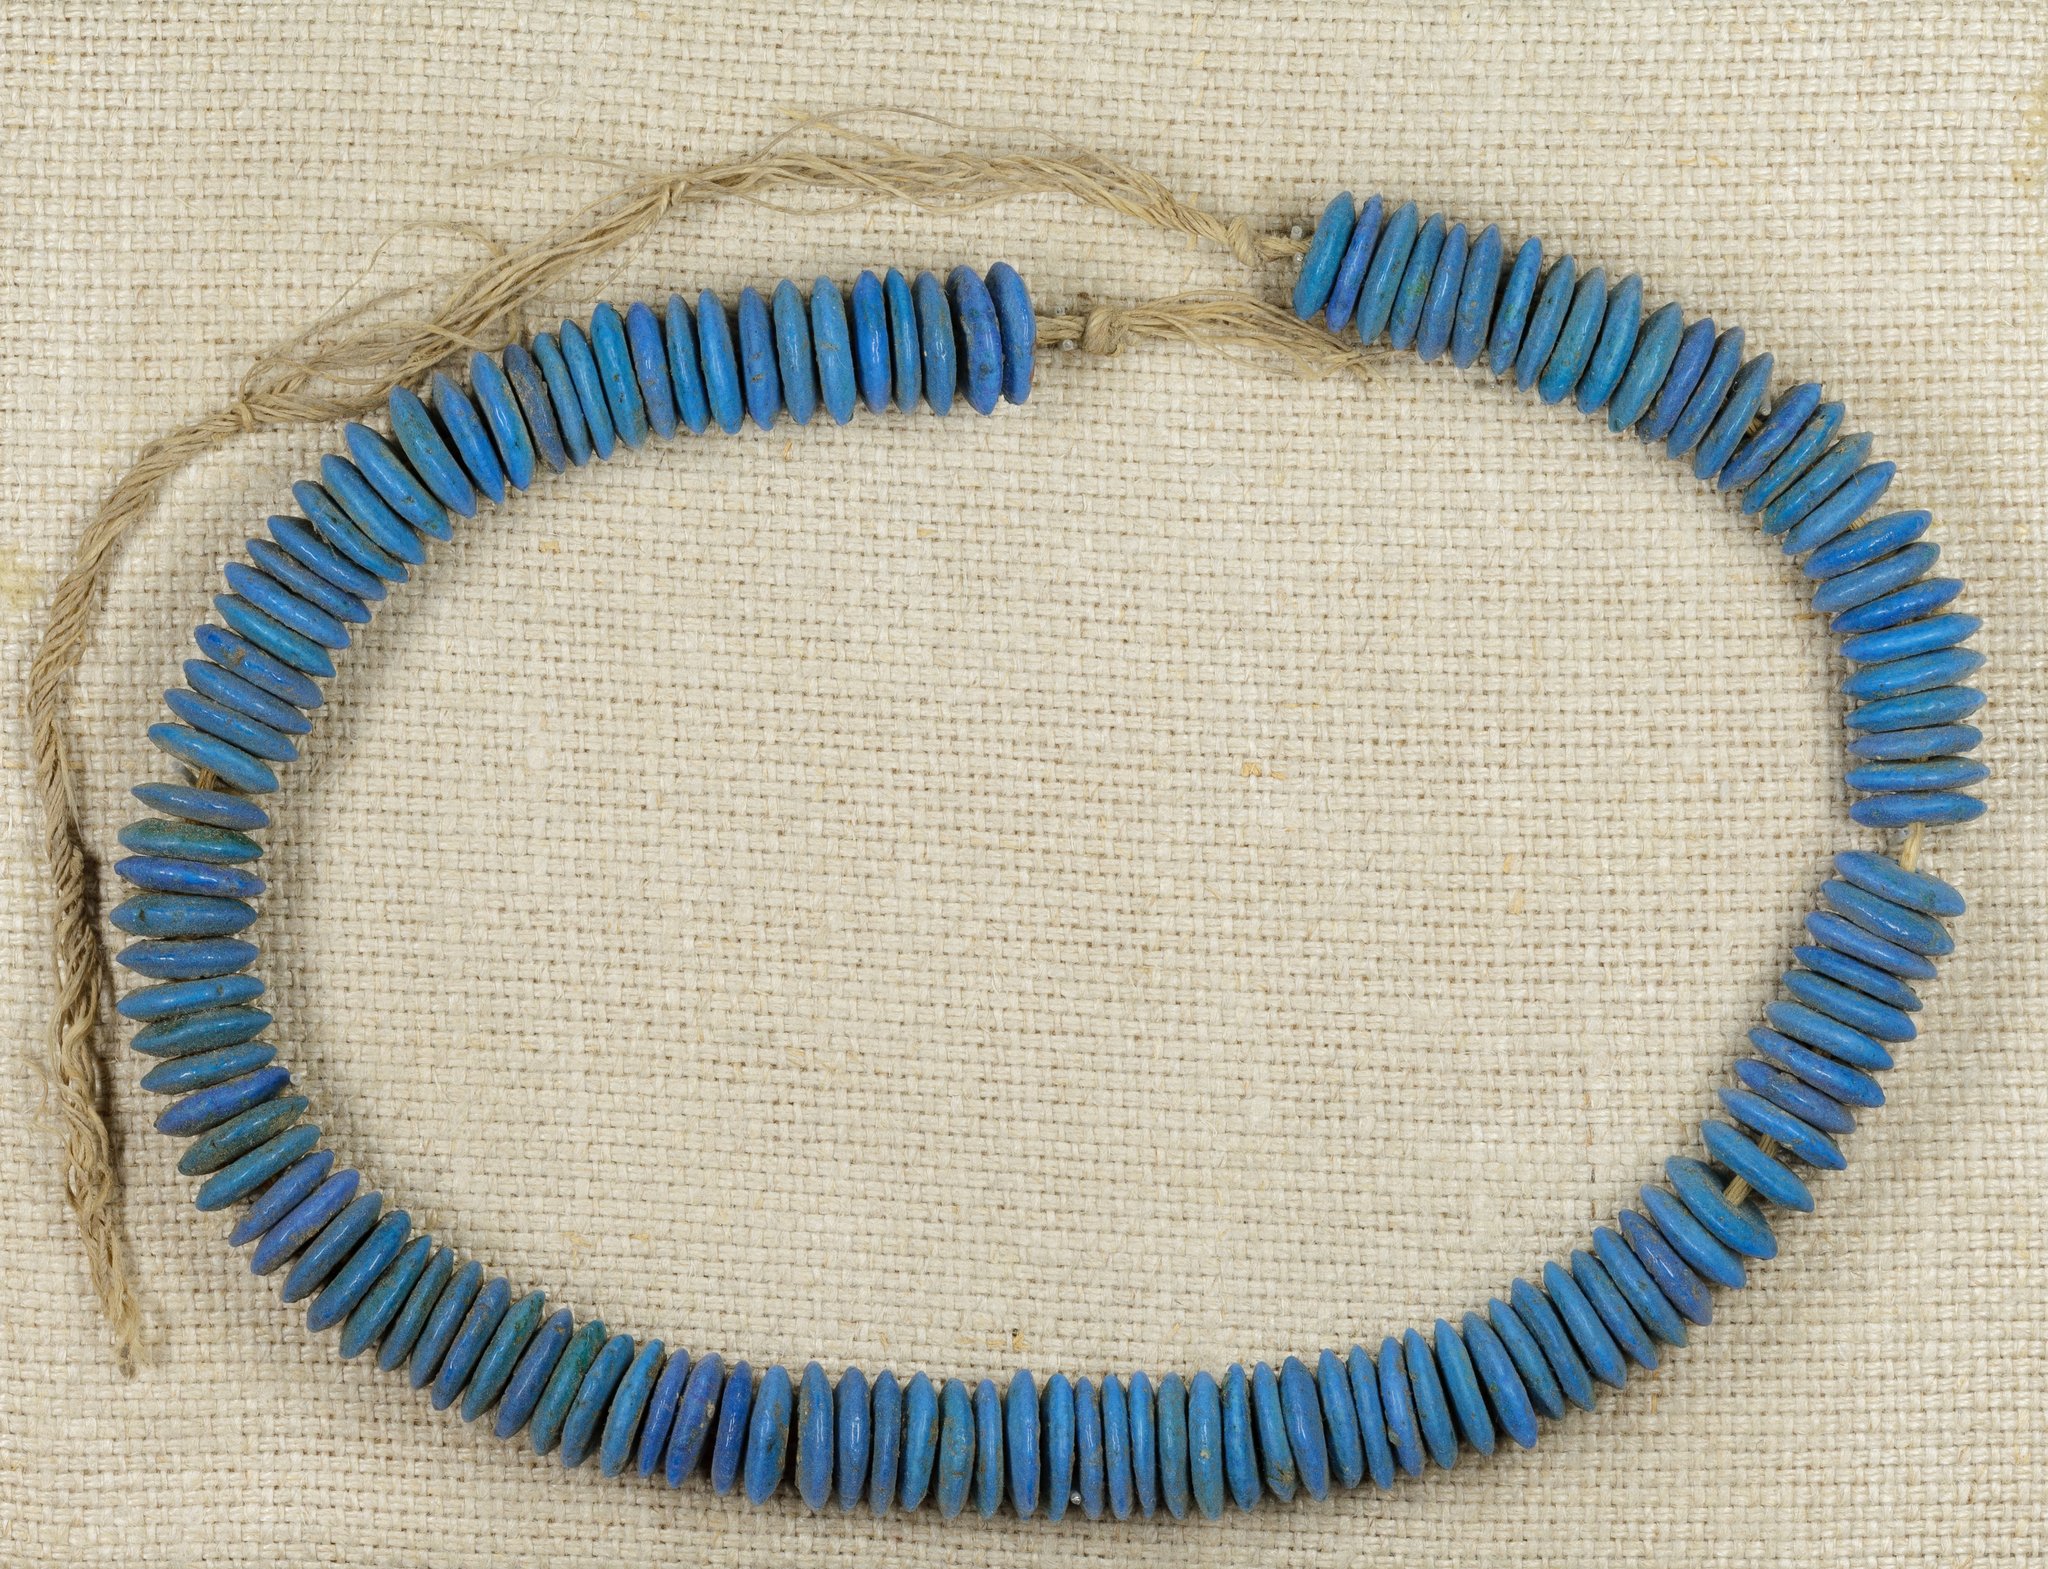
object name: necklace, shebiu, amenhotep, lentoid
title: Shebiu Necklace of Amenhotep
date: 1479-1458 BCE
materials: cord, faience, linen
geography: egypt